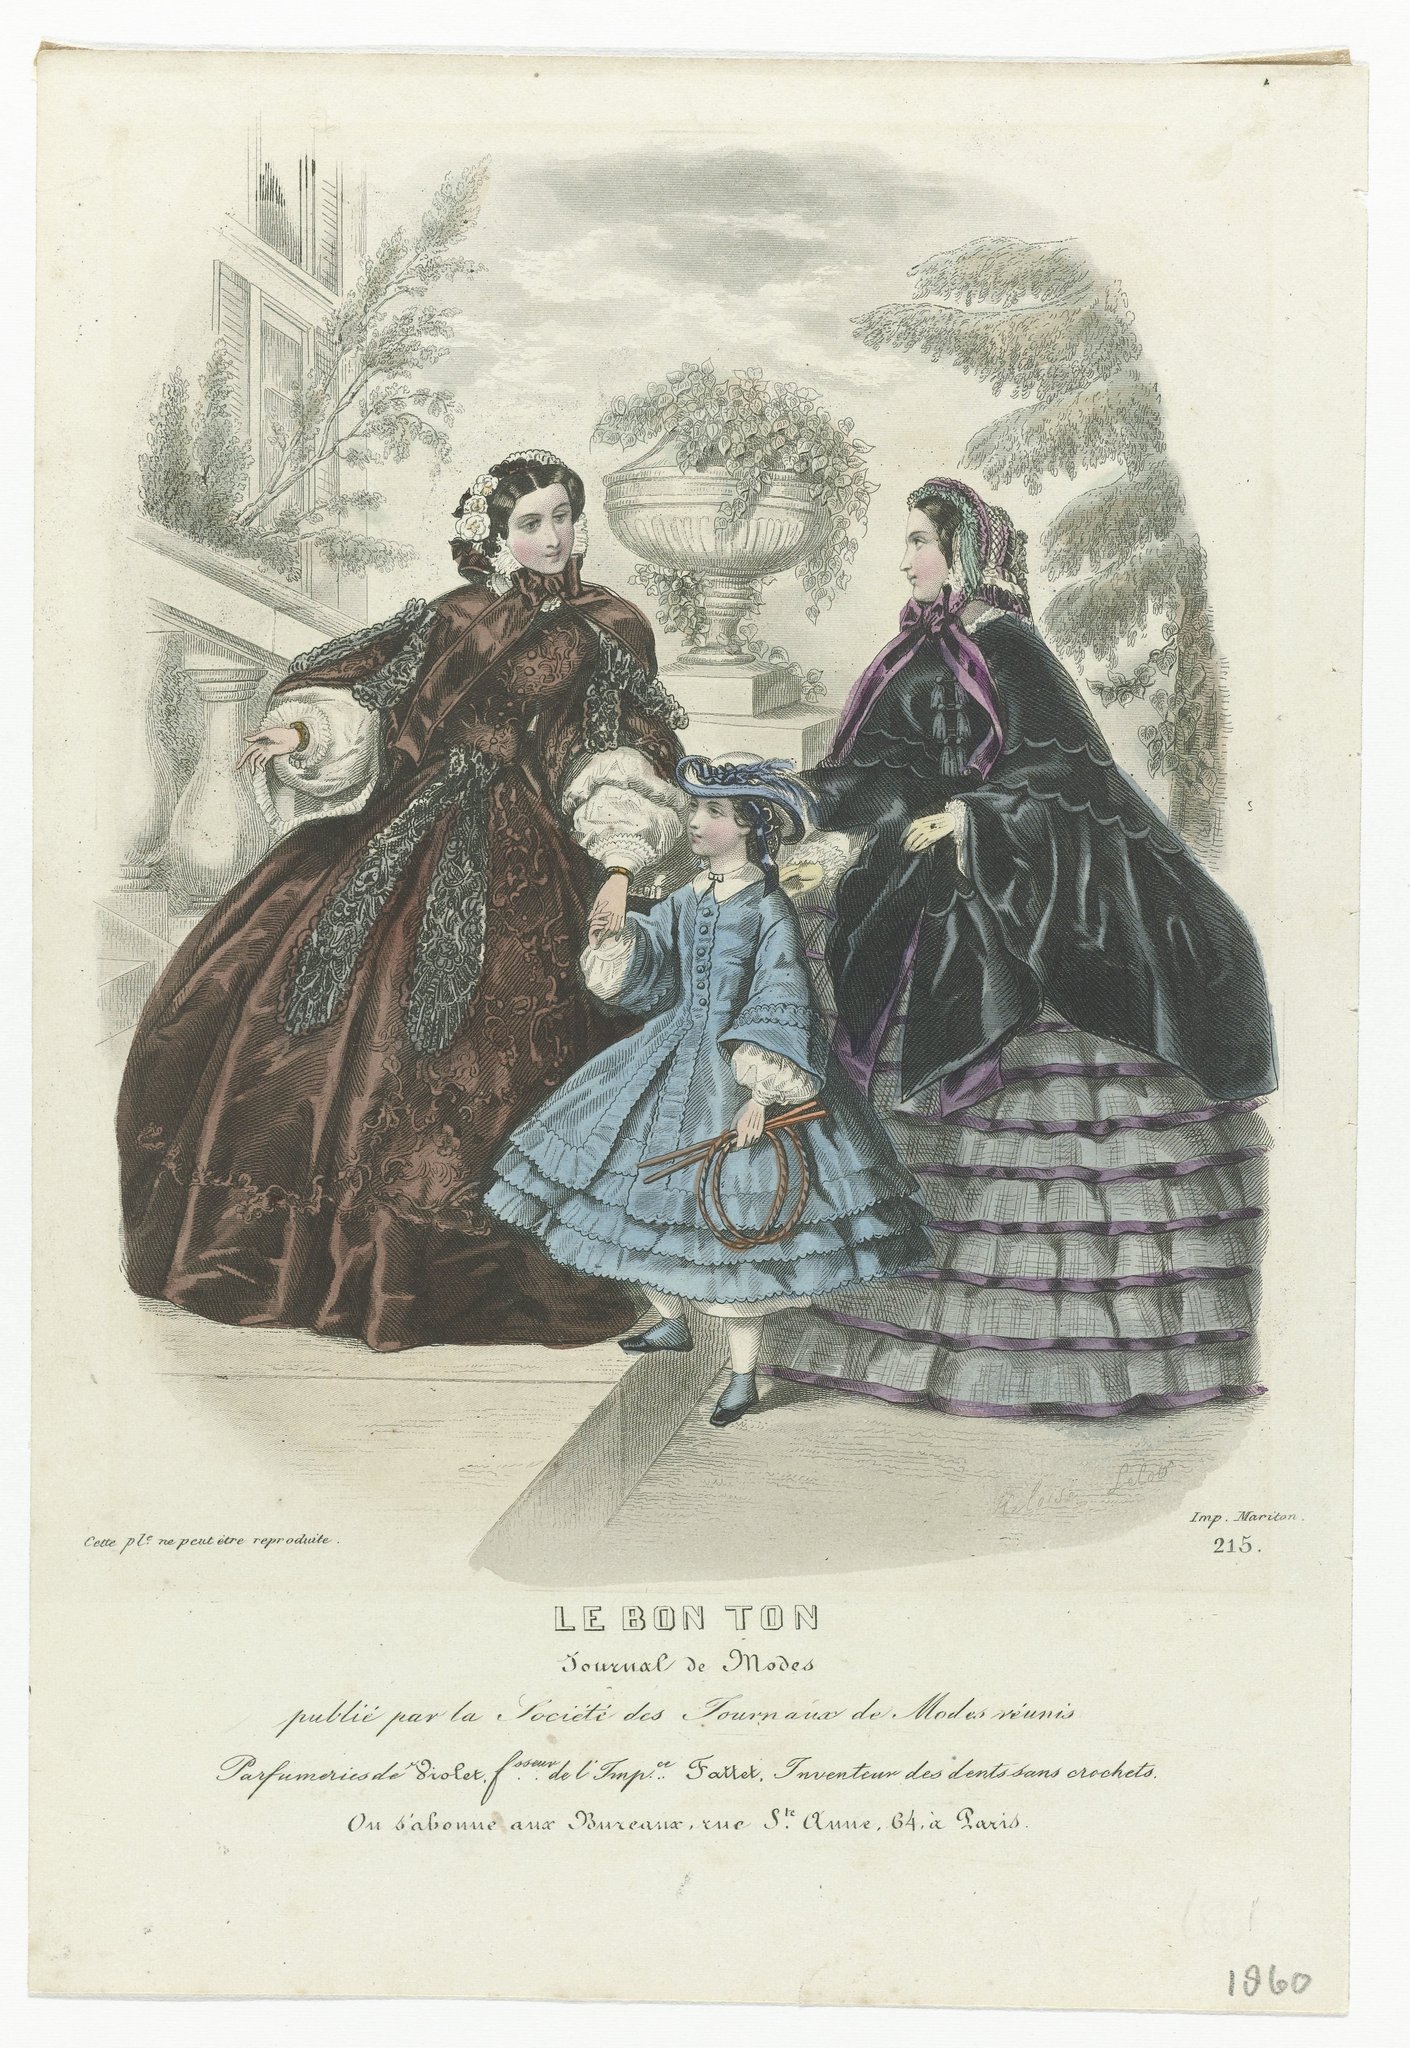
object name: fashion print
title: Le Bon Ton, Journal de Modes, 1860, No. 215 : Parfumeries de Violet (...)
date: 1860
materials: paper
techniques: engraving, hand coloring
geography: paris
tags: head-gear: hat (+ girls' clothes), coat (+ women's clothes), fashion plates, head-gear: hat (+ women's clothes), skirt (+ women's clothes), gloves, mittens, etc. (+ women's clothes), (playing with) toys, bracelet, wristlet (+ women's clothes), dress, gown (+ girls' clothes)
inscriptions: address: ‘On s'abonne aux Bureaux, rue S.te Anne, 64 à Paris.’, title: ‘Le Bon Ton / Journal de Modes’, caption: ‘publiée par la Société des Journaux de Modes Réunis / Parfumeries de Violet, f.sseur de l'Imp.ce Fattet, Inventeur des dents sans crochets.’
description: Twee vrouwen en een meisje onder aan een trap met tuinvaas. Het meisje heeft twee hoepels en twee stokjes in de hand. Onder de voorstelling enkele regels reclametekst voor verschillende producten. Prent uit het modetijdschrift Le Bon Ton (1834-1884).